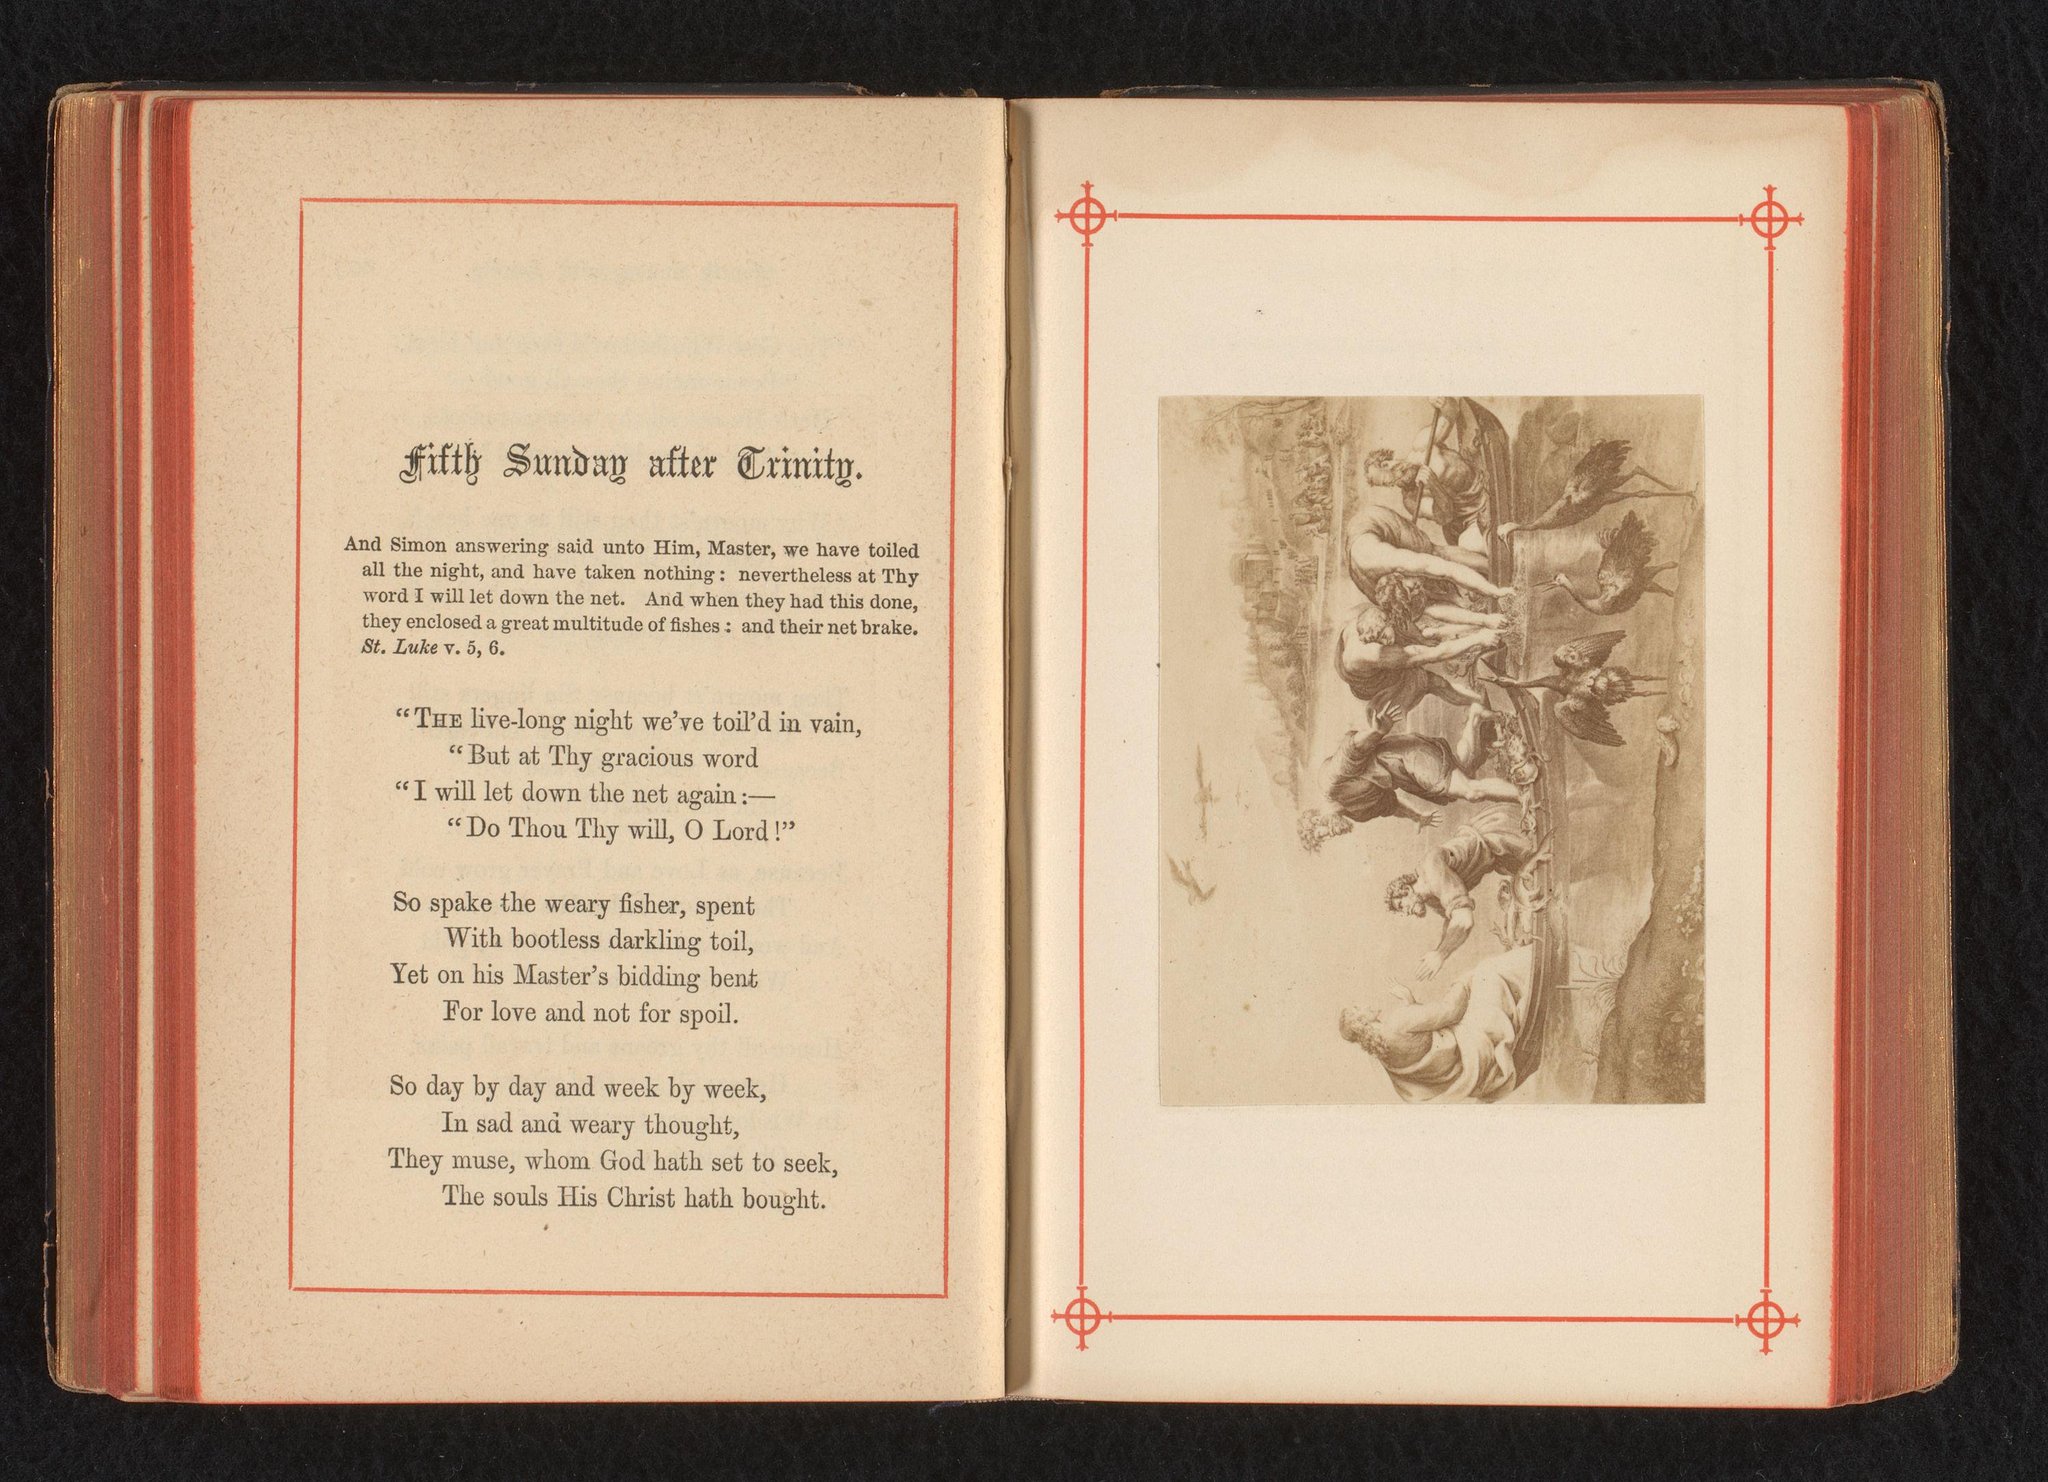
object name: photograph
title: Fotoreproductie van een wandtapijt van de wonderbaarlijke visvangst, ontworpen door Rafaël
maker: Anonymous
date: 1861-1866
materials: paper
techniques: albumen print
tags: the miraculous draught of fishes (before the resurrection) on the lake of gennesaret (sea of galilee); james and john helping to bring in the nets (luke 5:1-11)